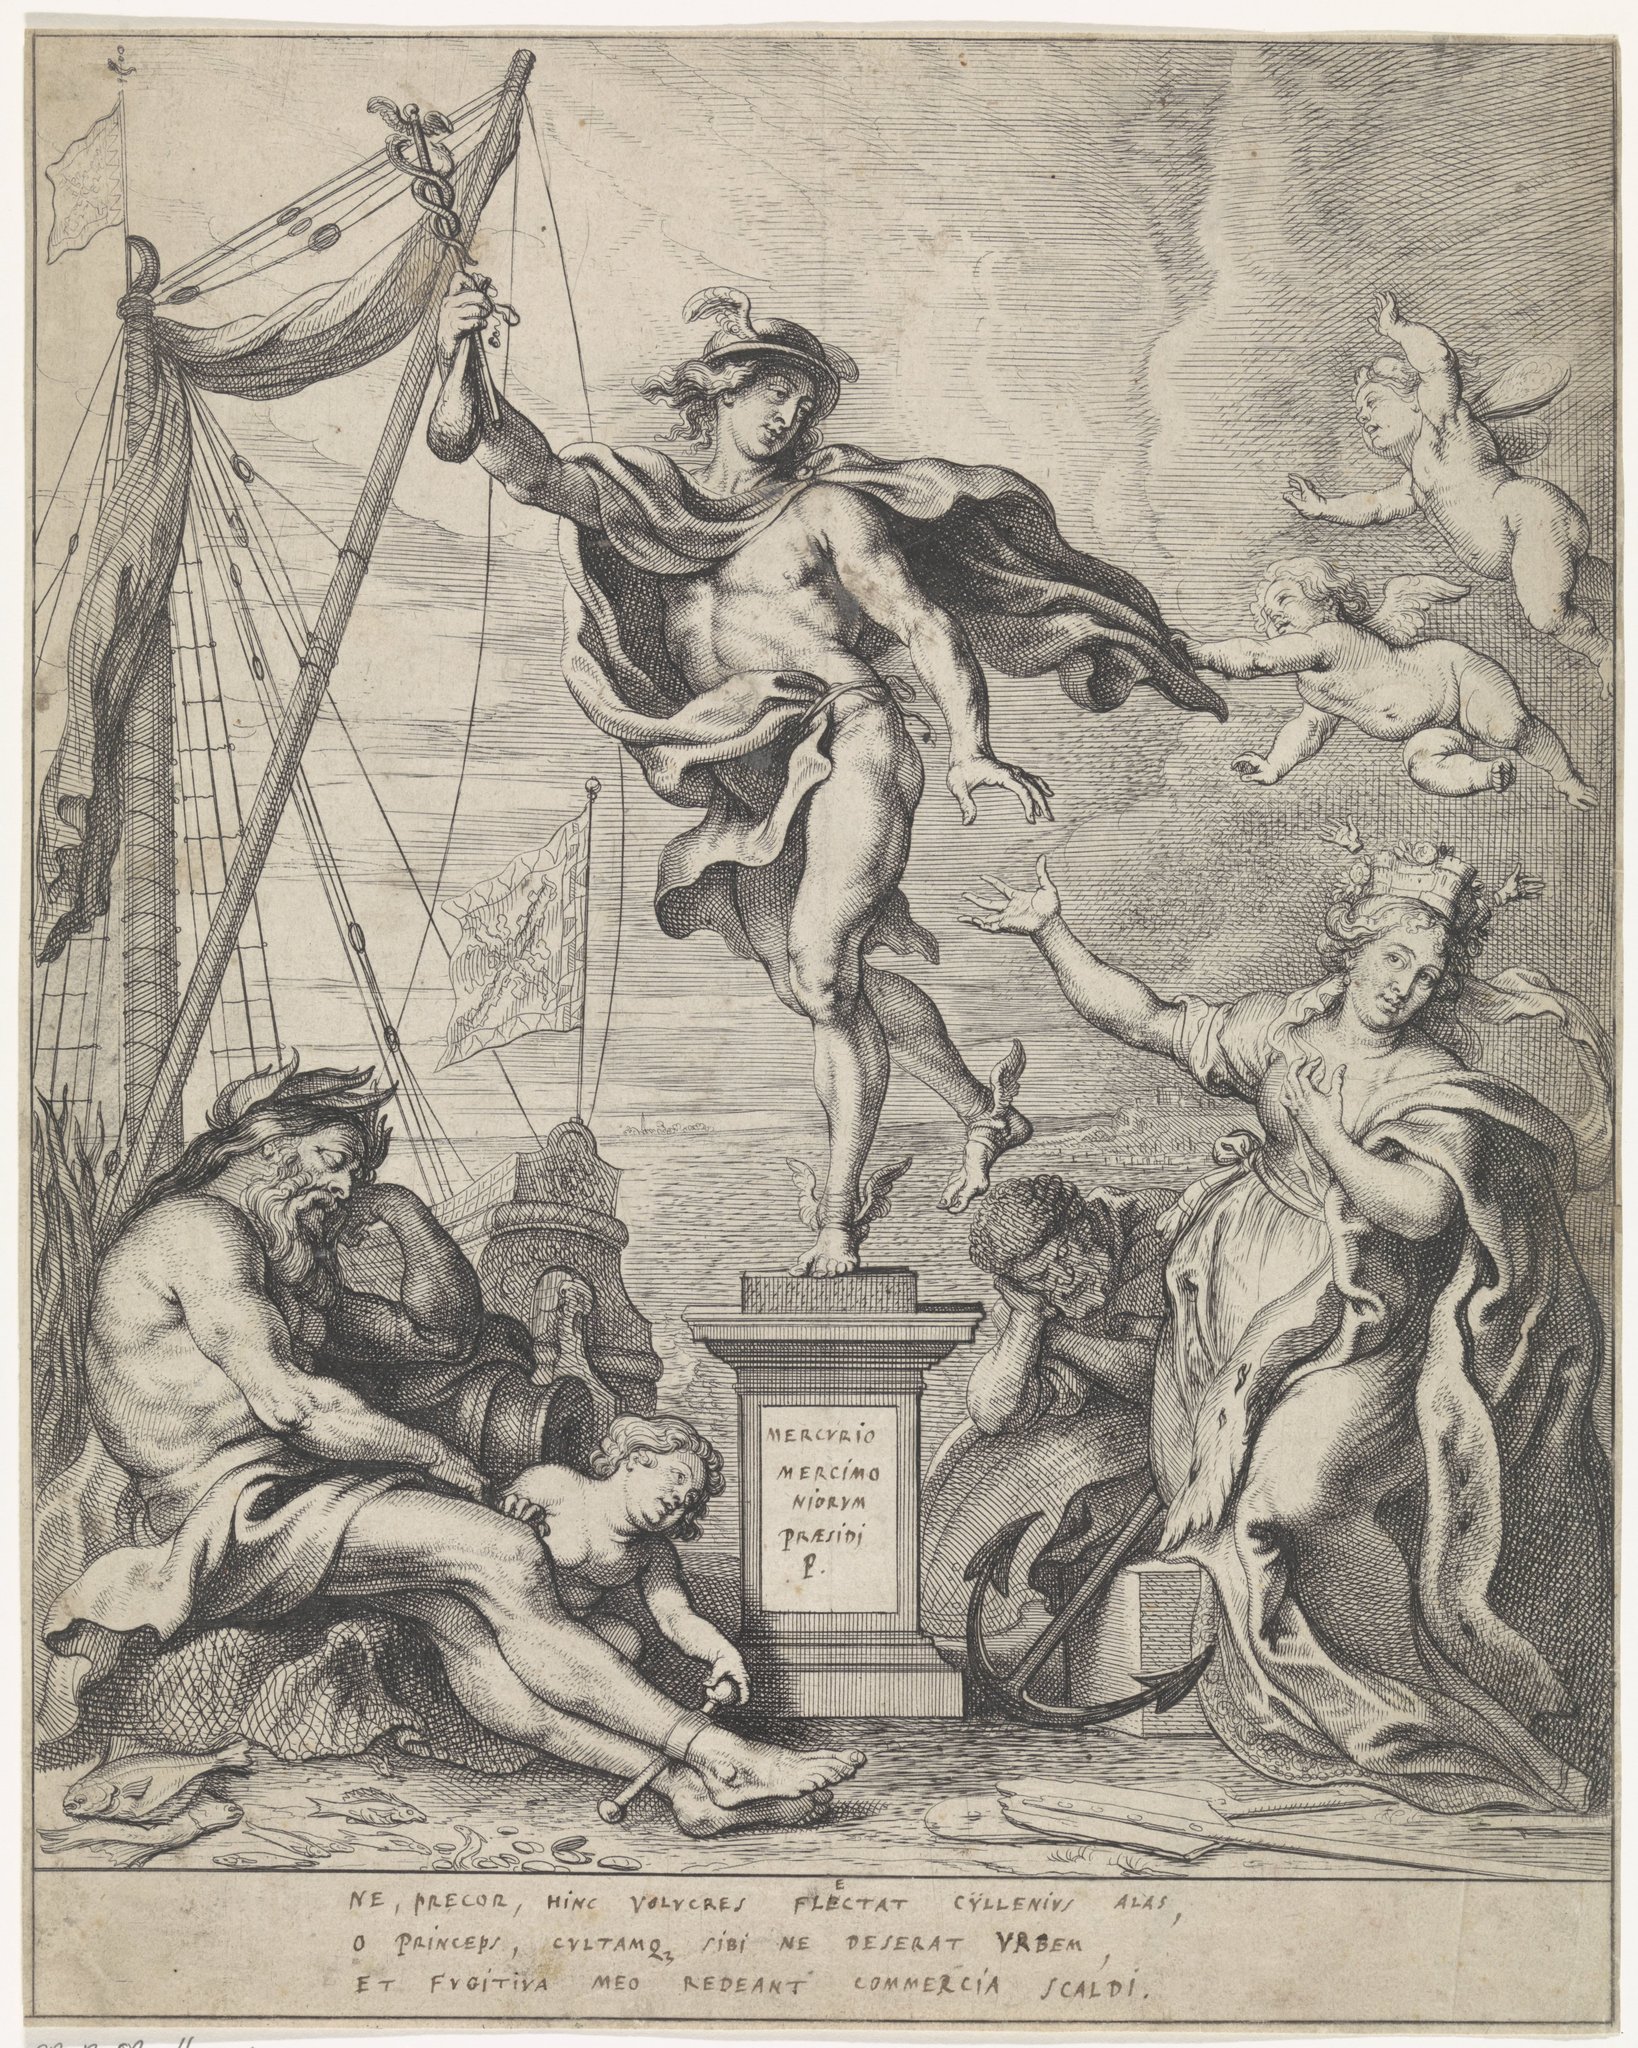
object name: print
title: Mercurius verlaat Antwerpen; intocht van Ferdinand te Antwerpen in 1635 (nr. 34)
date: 1640-1642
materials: paper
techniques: engraving, etching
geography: antwerp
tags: specific aspects, allegorical aspects of neptune; neptune as patron, specific aspects, allegorical aspects of mercury; mercury as patron, other decorative structures (~ triumphal entry, etc.)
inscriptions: collector's mark: Lugt 240, inscription: ‘Mercurio mercimo niorym praesidi P. / Ne, precor, hinc volvcres flectat cyllenius alas, o princeps, cultamo sibi ne deserat urbem, et fugitiva meo redeant commercia scaldi.’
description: Mercurius verlaat Antwerpen. Door de oorlog en de afsluiting van de Schelde dreigt de handel in Antwerpen onder te gaan. Mercurius met links de slapende riviergod van de Schelde, rechts de stedemaagd van Antwerpen. Met onderschrift van drie handgeschreven regels in het Latijn. De centrale voorstelling op het toneel van Mercurius, opgesteld op de Sint-Jansbrug. Blad nr. 34 in een geheel van 43 platen die de uitgave van de beschrijving van de intocht van de Kardinaal Infant Ferdinand van Oostenrijk te Antwerpen op 5 mei 1635 als de nieuwe landvoogd voor de Spaanse Nederlanden illustreren.